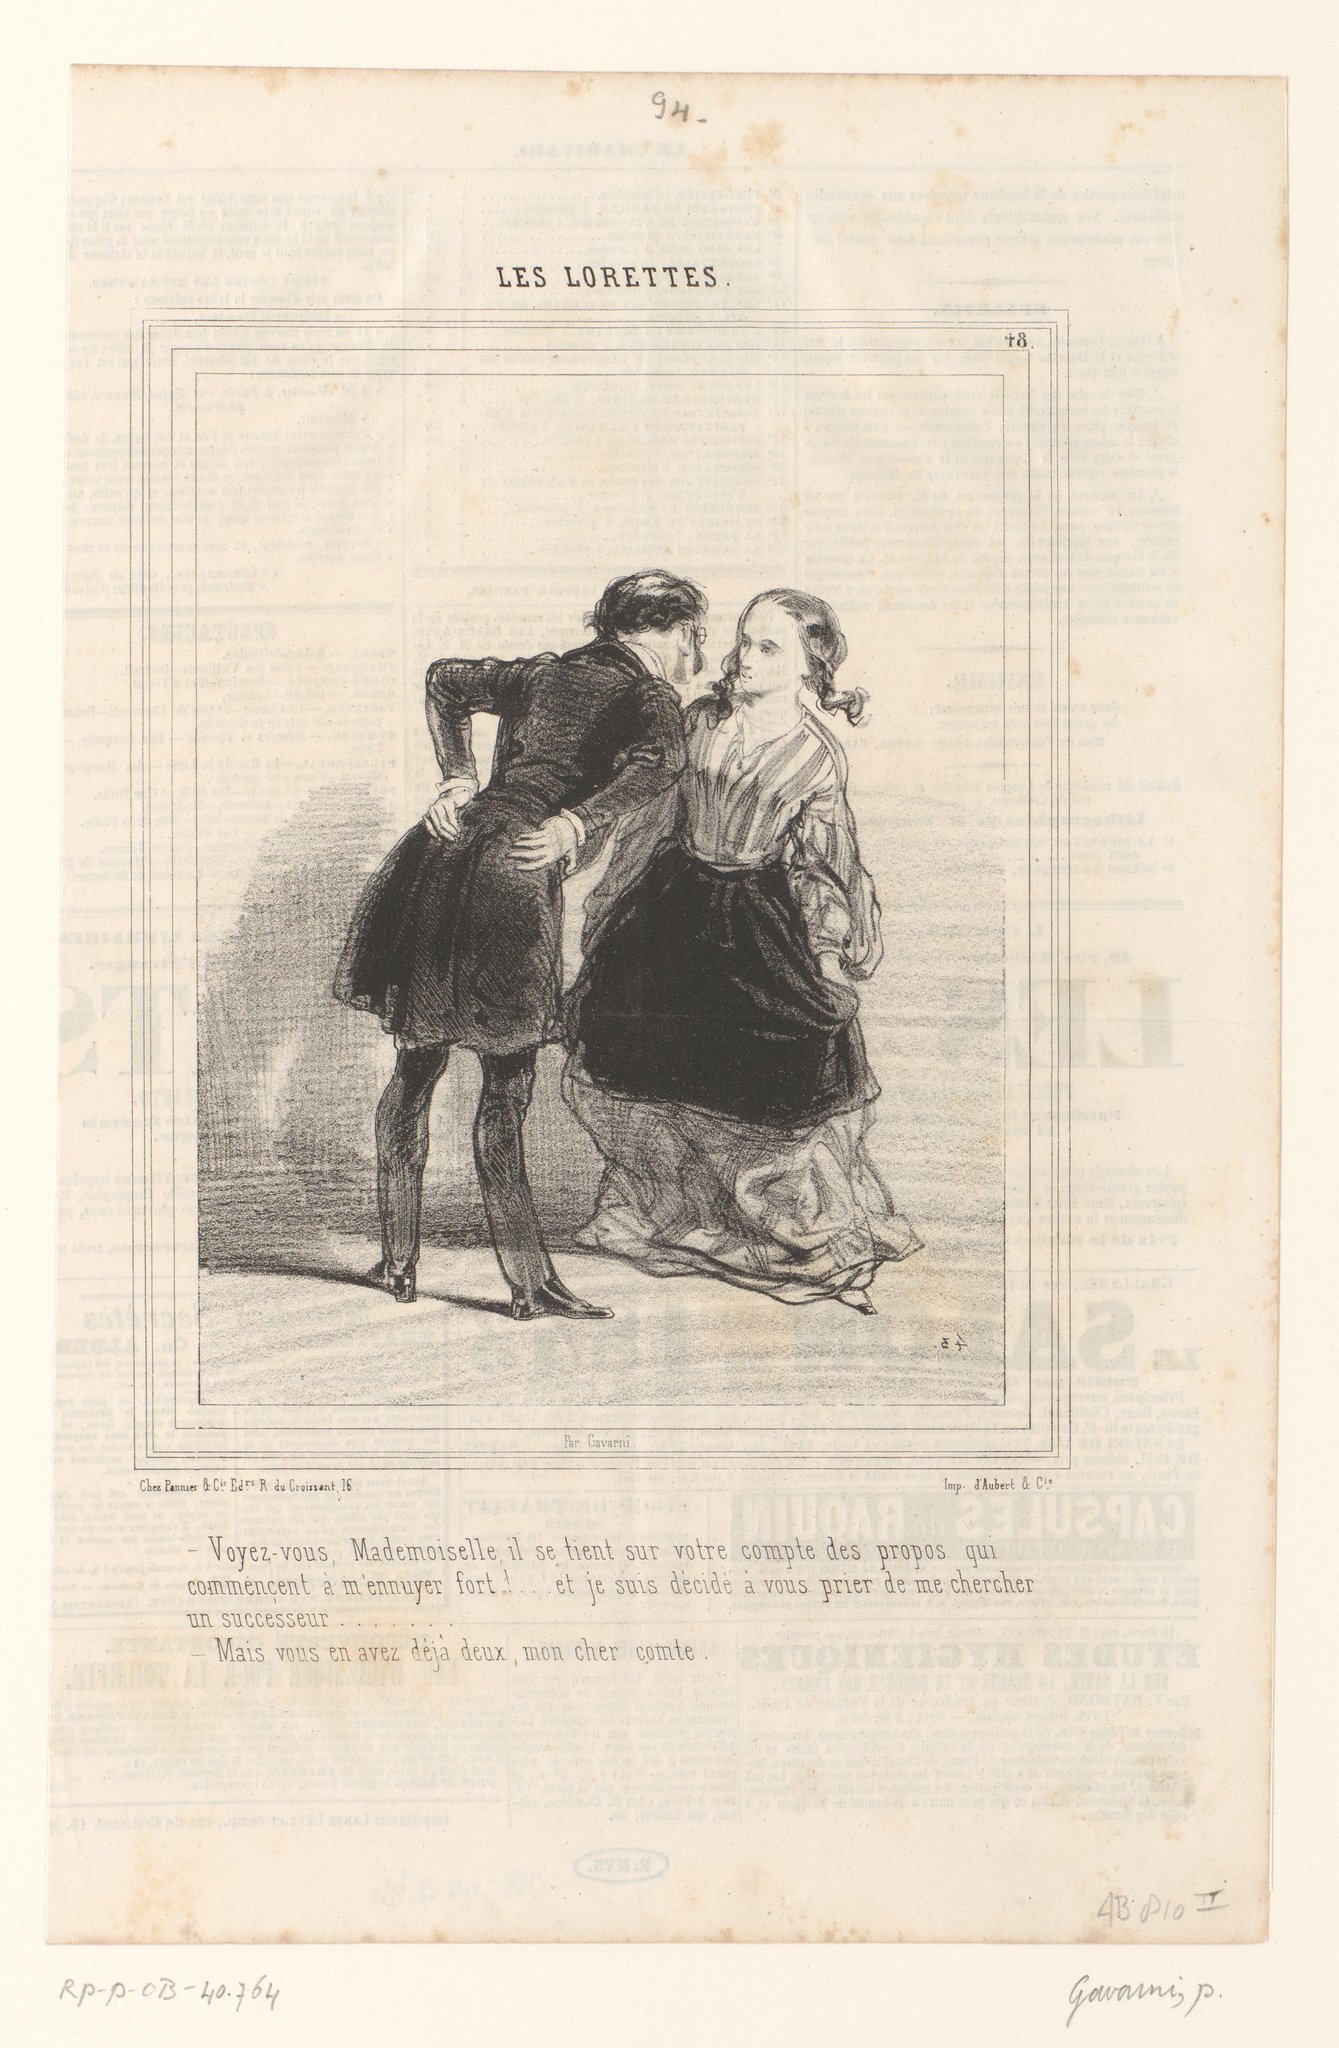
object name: print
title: Graaf ontslaat dienstmeid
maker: paul gavarni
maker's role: draughtsman, print maker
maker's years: 1804-1866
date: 1843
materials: paper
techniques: lithograph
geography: paris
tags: employer ~ employee, quarrel, argument, maid ~ house personnel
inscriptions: collector's mark: Lugt 2228a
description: Prent gebruikt voor: Le Charivari, 9 april 1843.